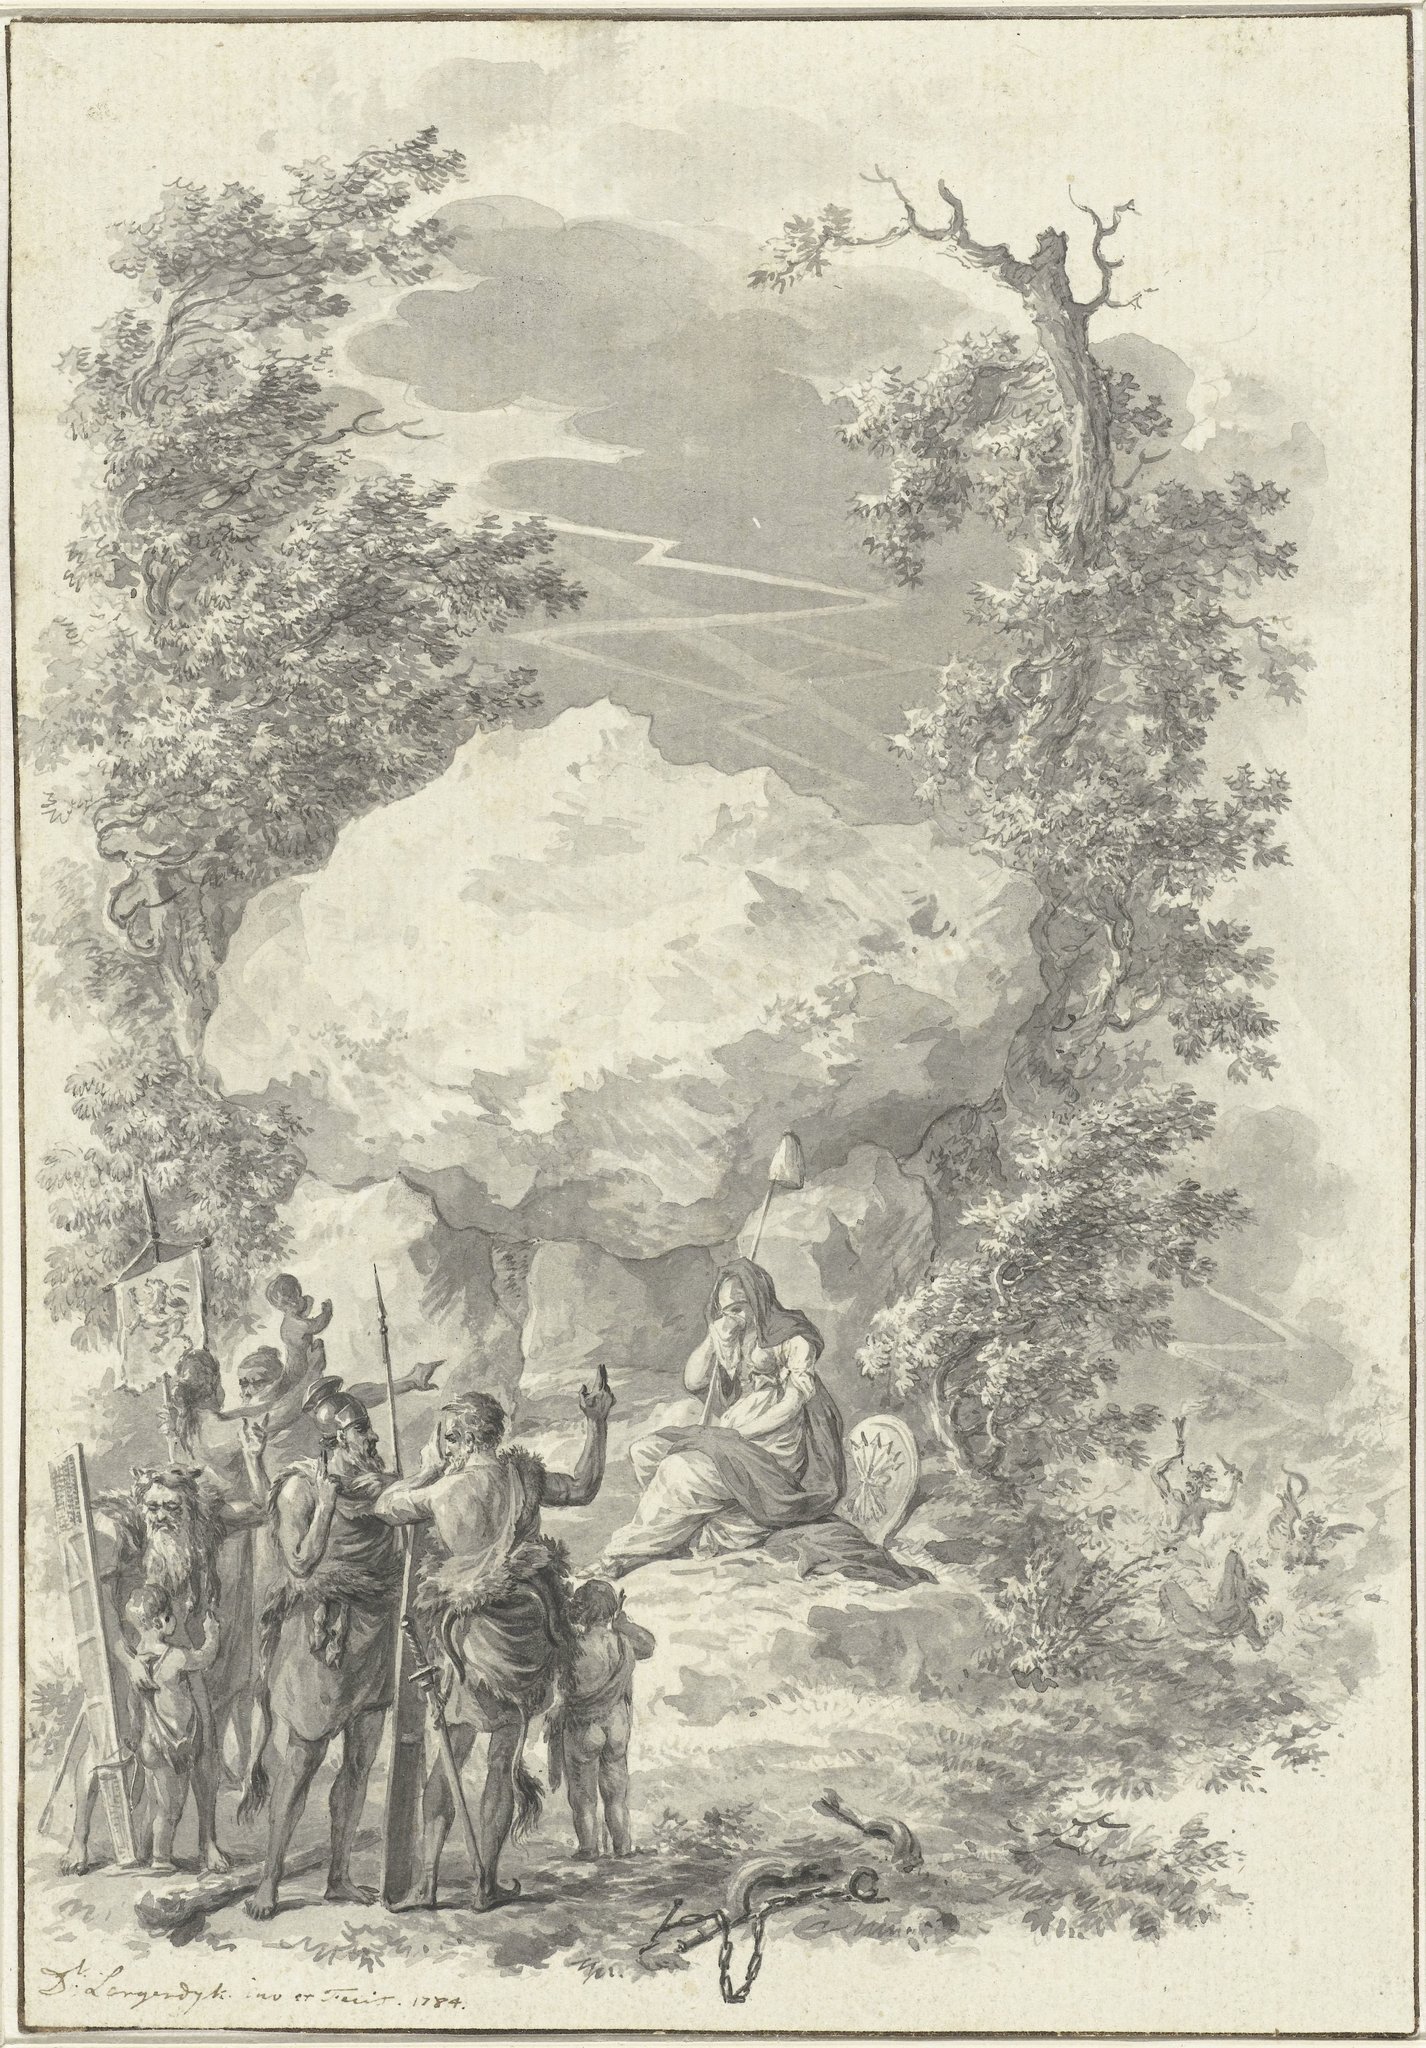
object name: drawing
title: Allegorie op de dood van Joan Derk van der Capellen tot den Pol, 1784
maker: dirk langendijk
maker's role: draughtsman, painter, print maker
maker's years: 1748-1805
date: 1784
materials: ink, paper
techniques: brush, pen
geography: northern netherlands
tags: joan derk van der capellen tot den pol, extinct, 'historical' peoples (with name), megalithic chambered tomb, dolmen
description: Allegorie op het overlijden van Joan Derk van der Capellen tot den Pol, 6 juni 1784. Een groep Bataven wijst naar een vers op de overledene op de deksteen van een hunebed. Onder de rots zit de treurende Nederlandse Maagd. Vanuit de wolken bliksemschichten. Ontwerp voor een prent.